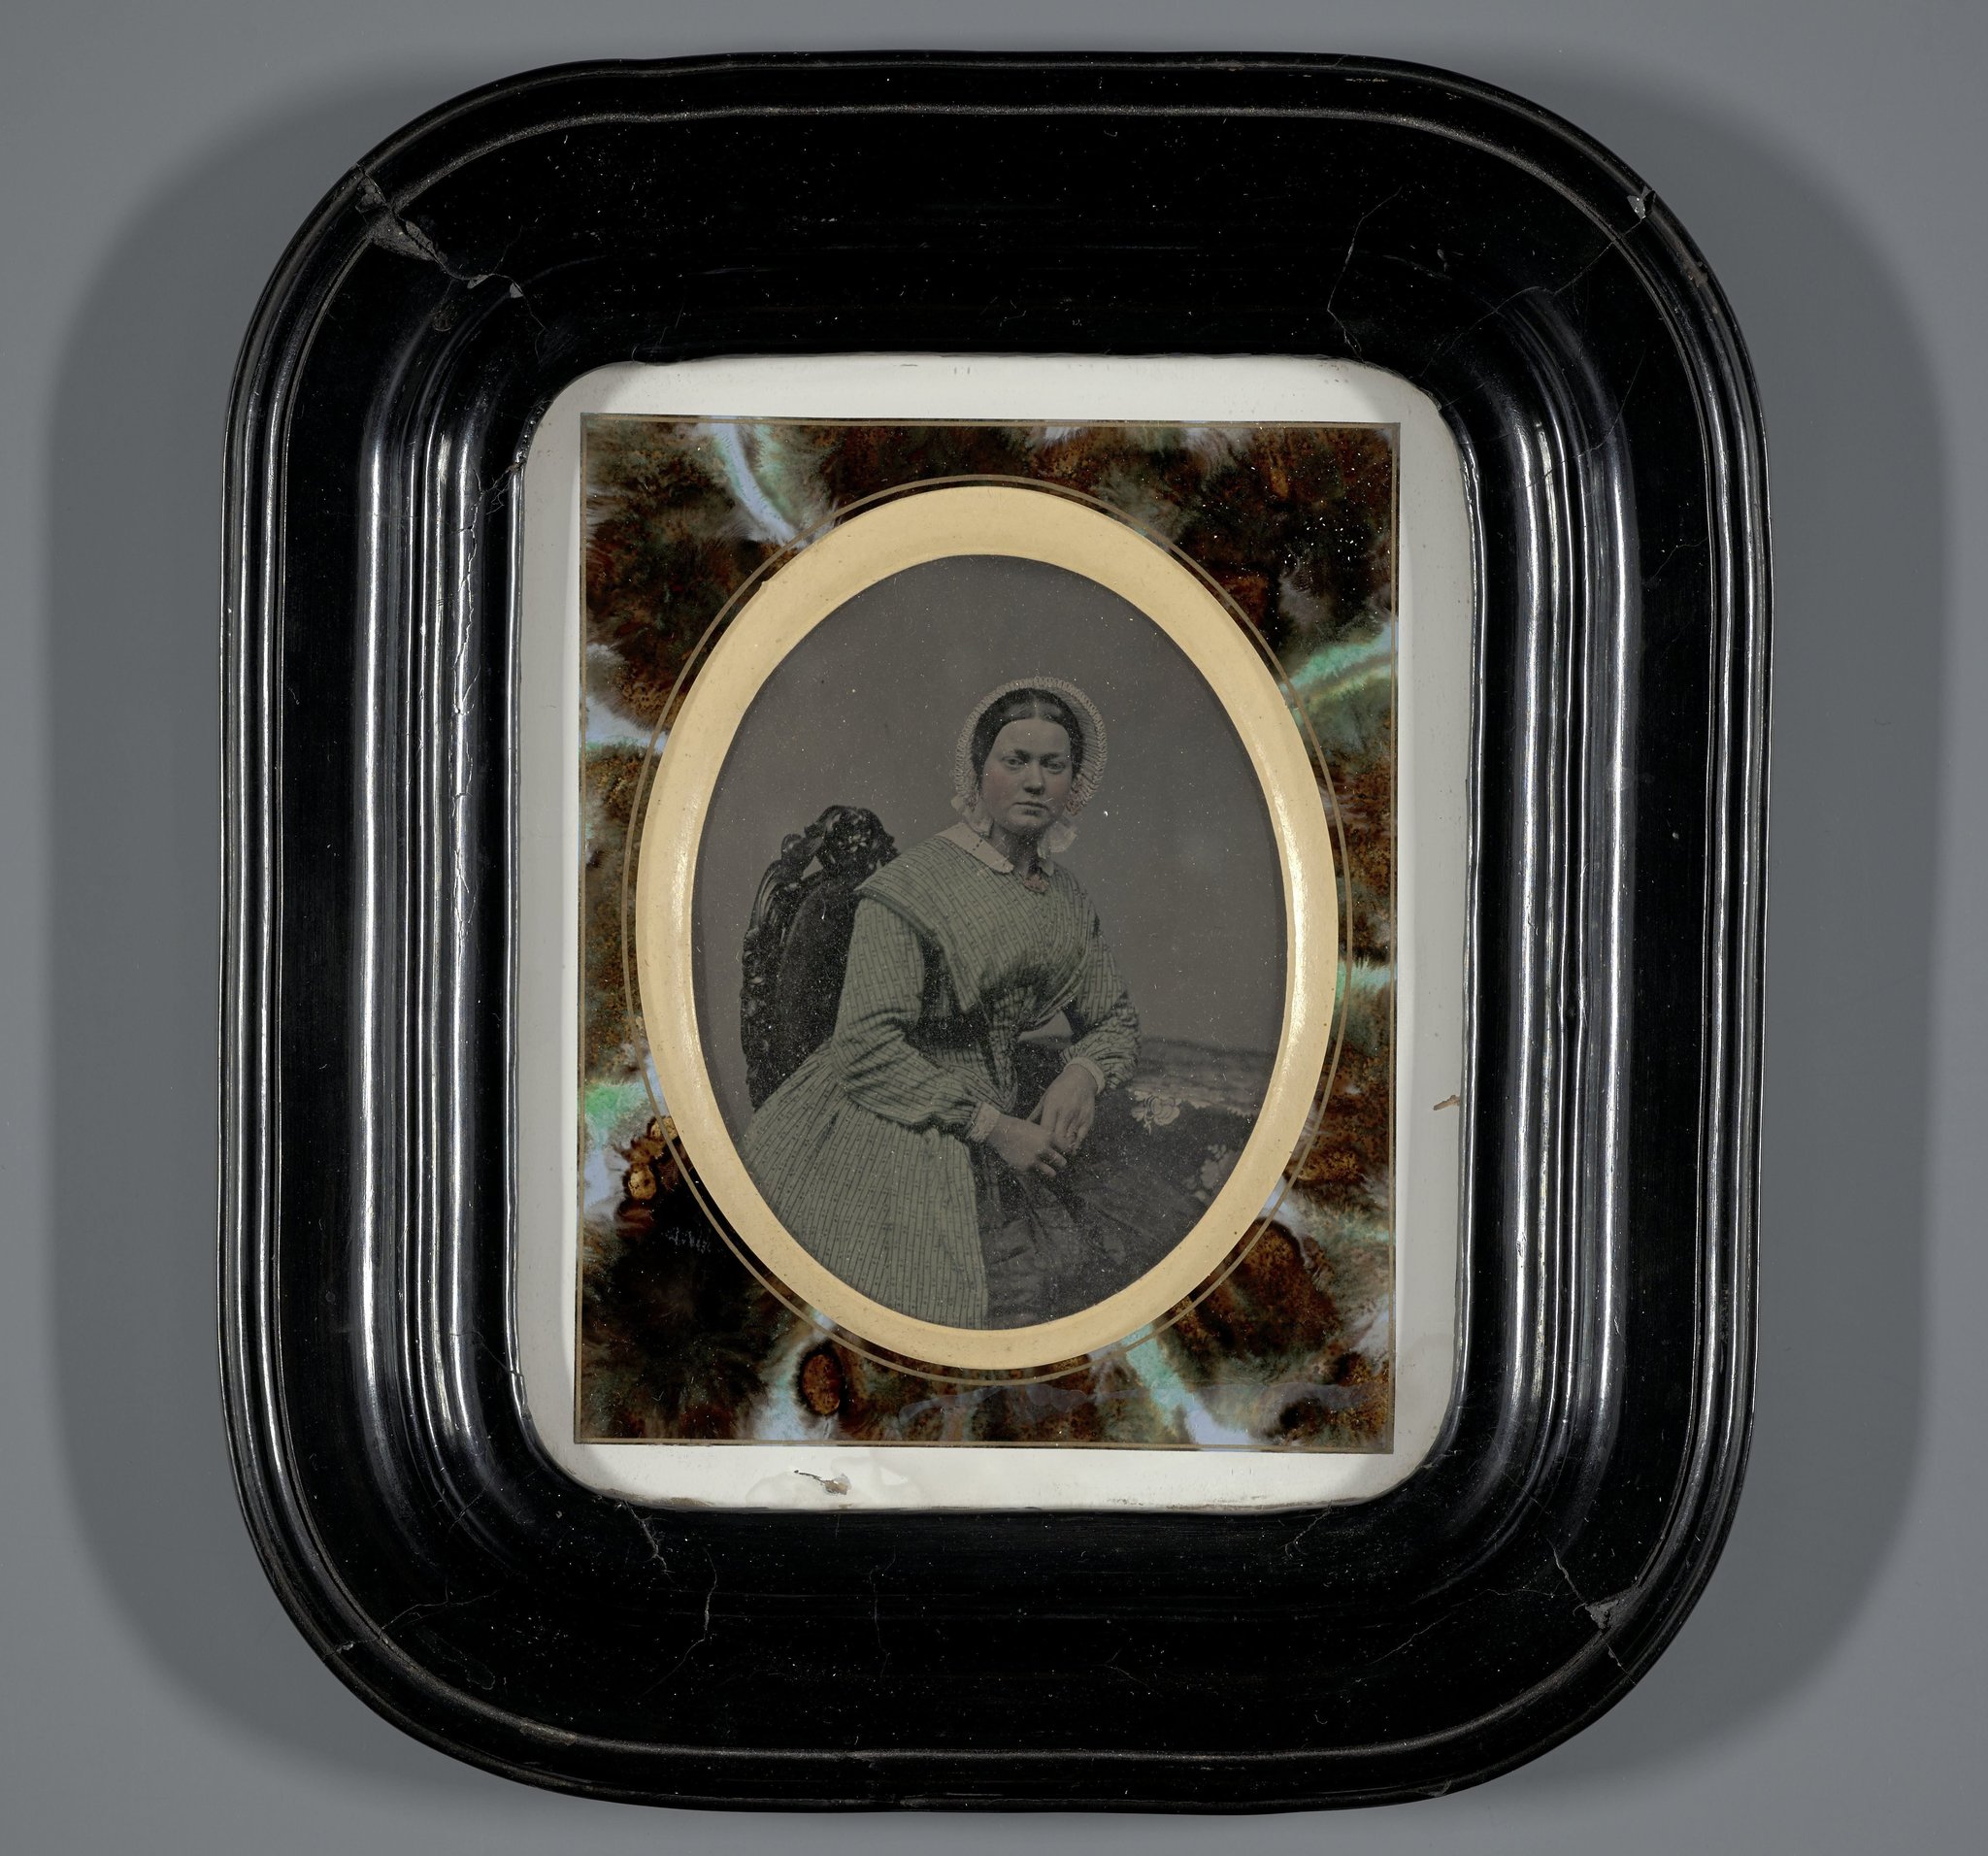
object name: photograph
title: Portret van een vrouw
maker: Anonymous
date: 1855-1860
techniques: ambrotype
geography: netherlands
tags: historical persons - bb - woman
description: Ingekleurd portret in zwarte lijst met versierd passe-partout.